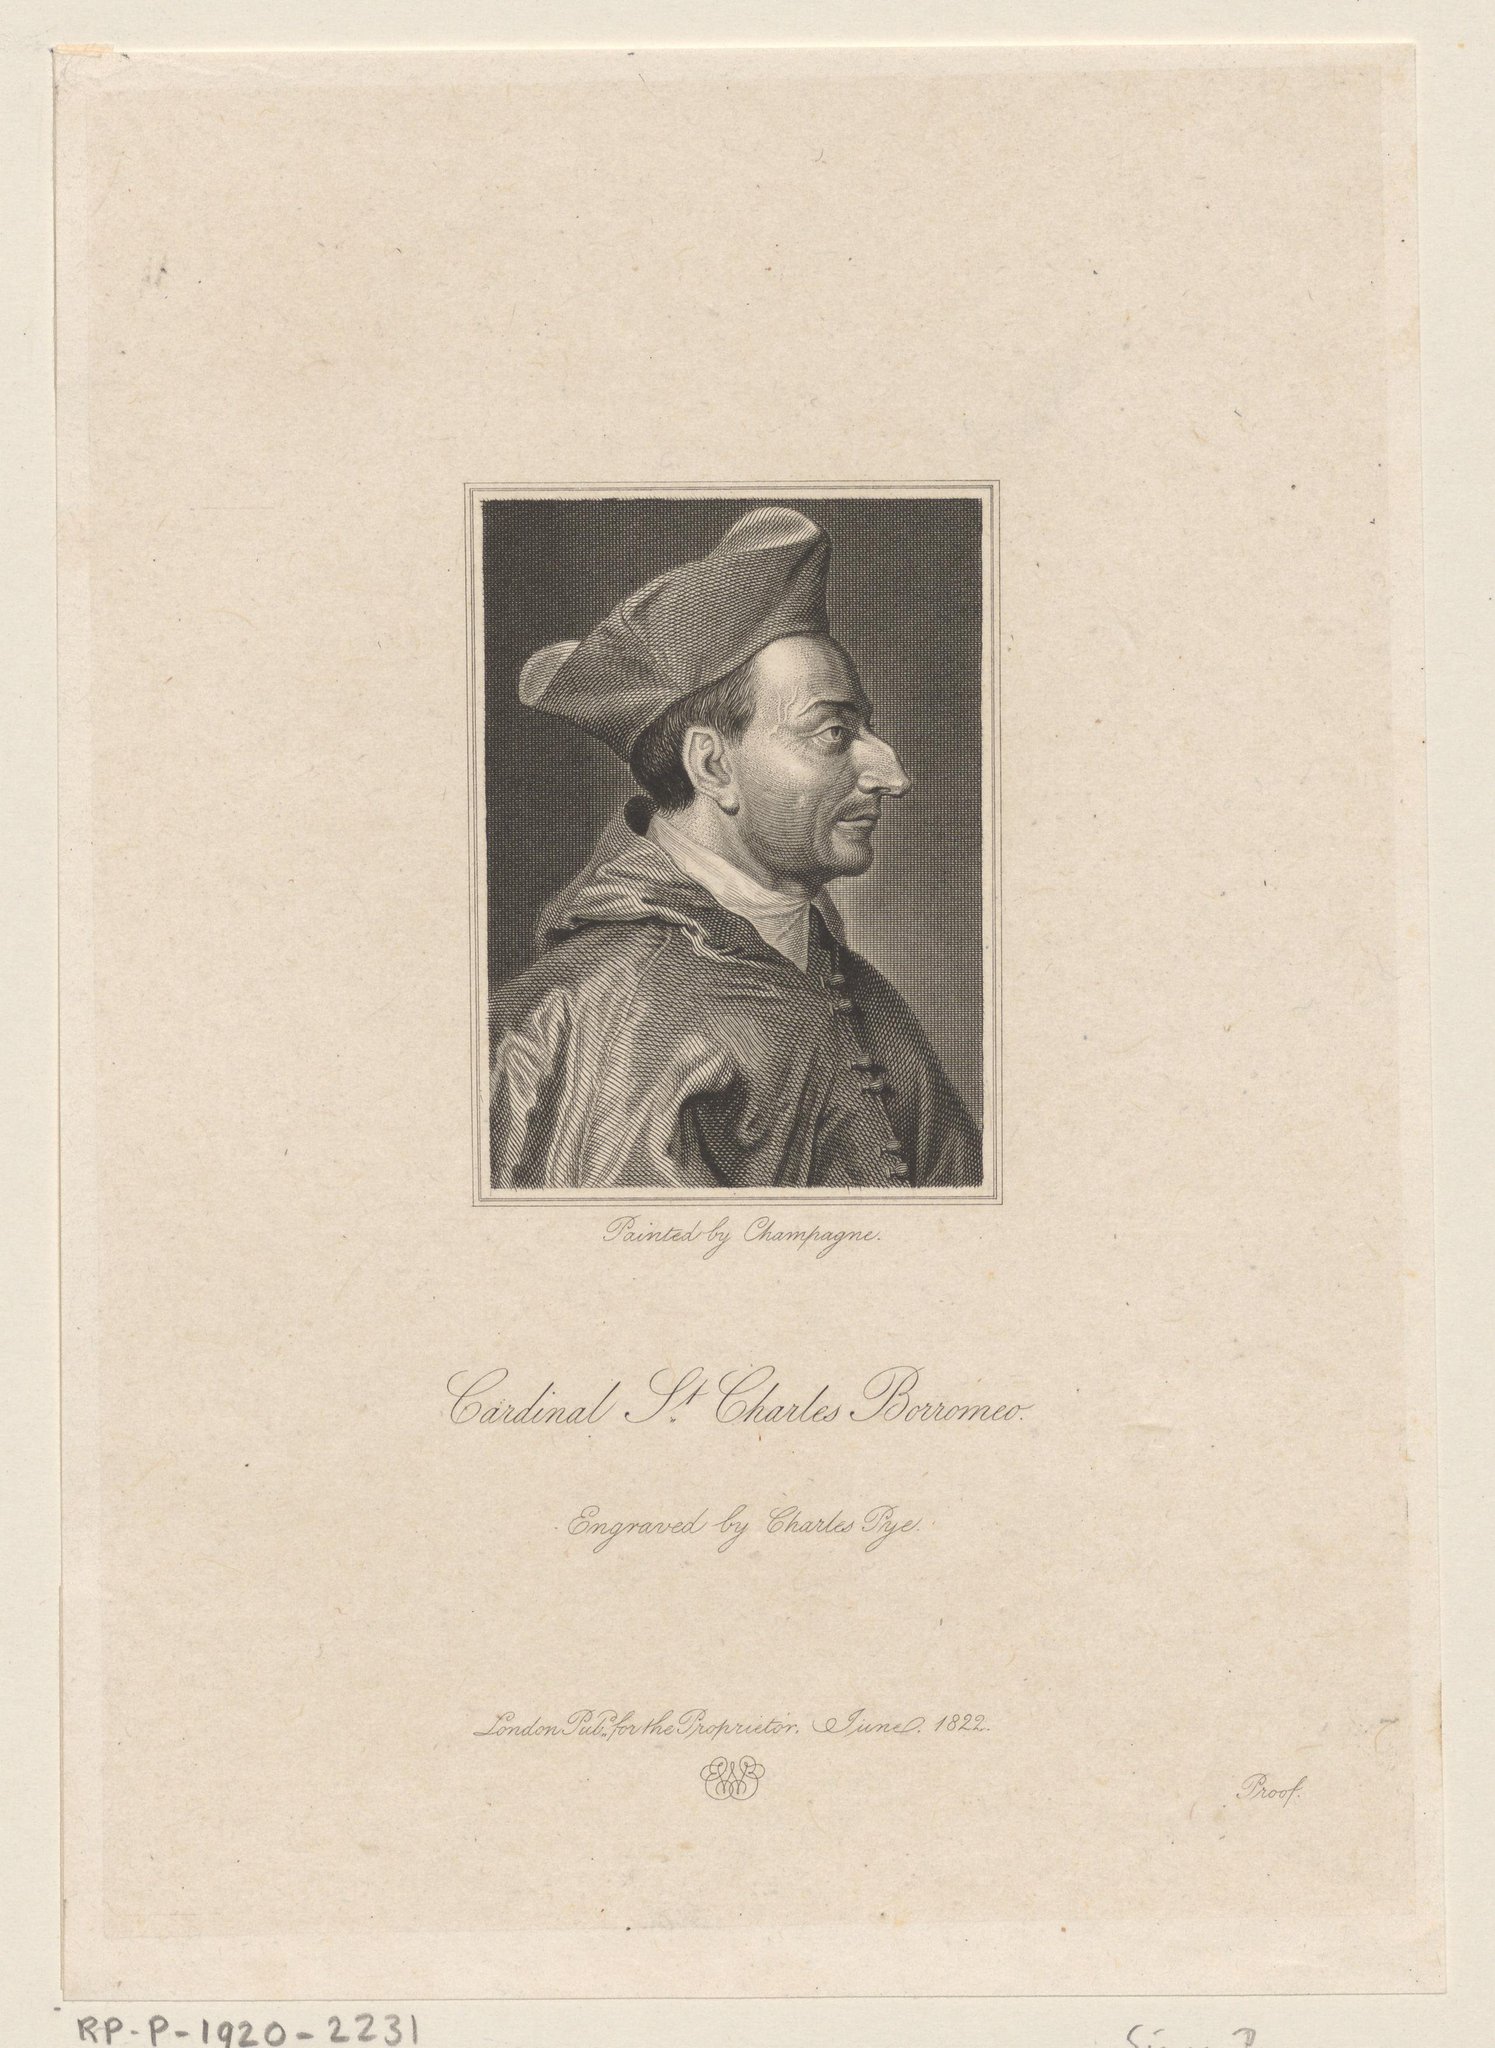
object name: print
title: Portret van Carlo Borromeo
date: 1822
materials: paper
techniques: engraving, etching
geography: london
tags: cardinal, historical persons, saints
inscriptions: collector's mark: Lugt 2228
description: Prent gebruikt in: Walmsley, Edward. Physiognomical portraits. Londen: John Major, 1822.